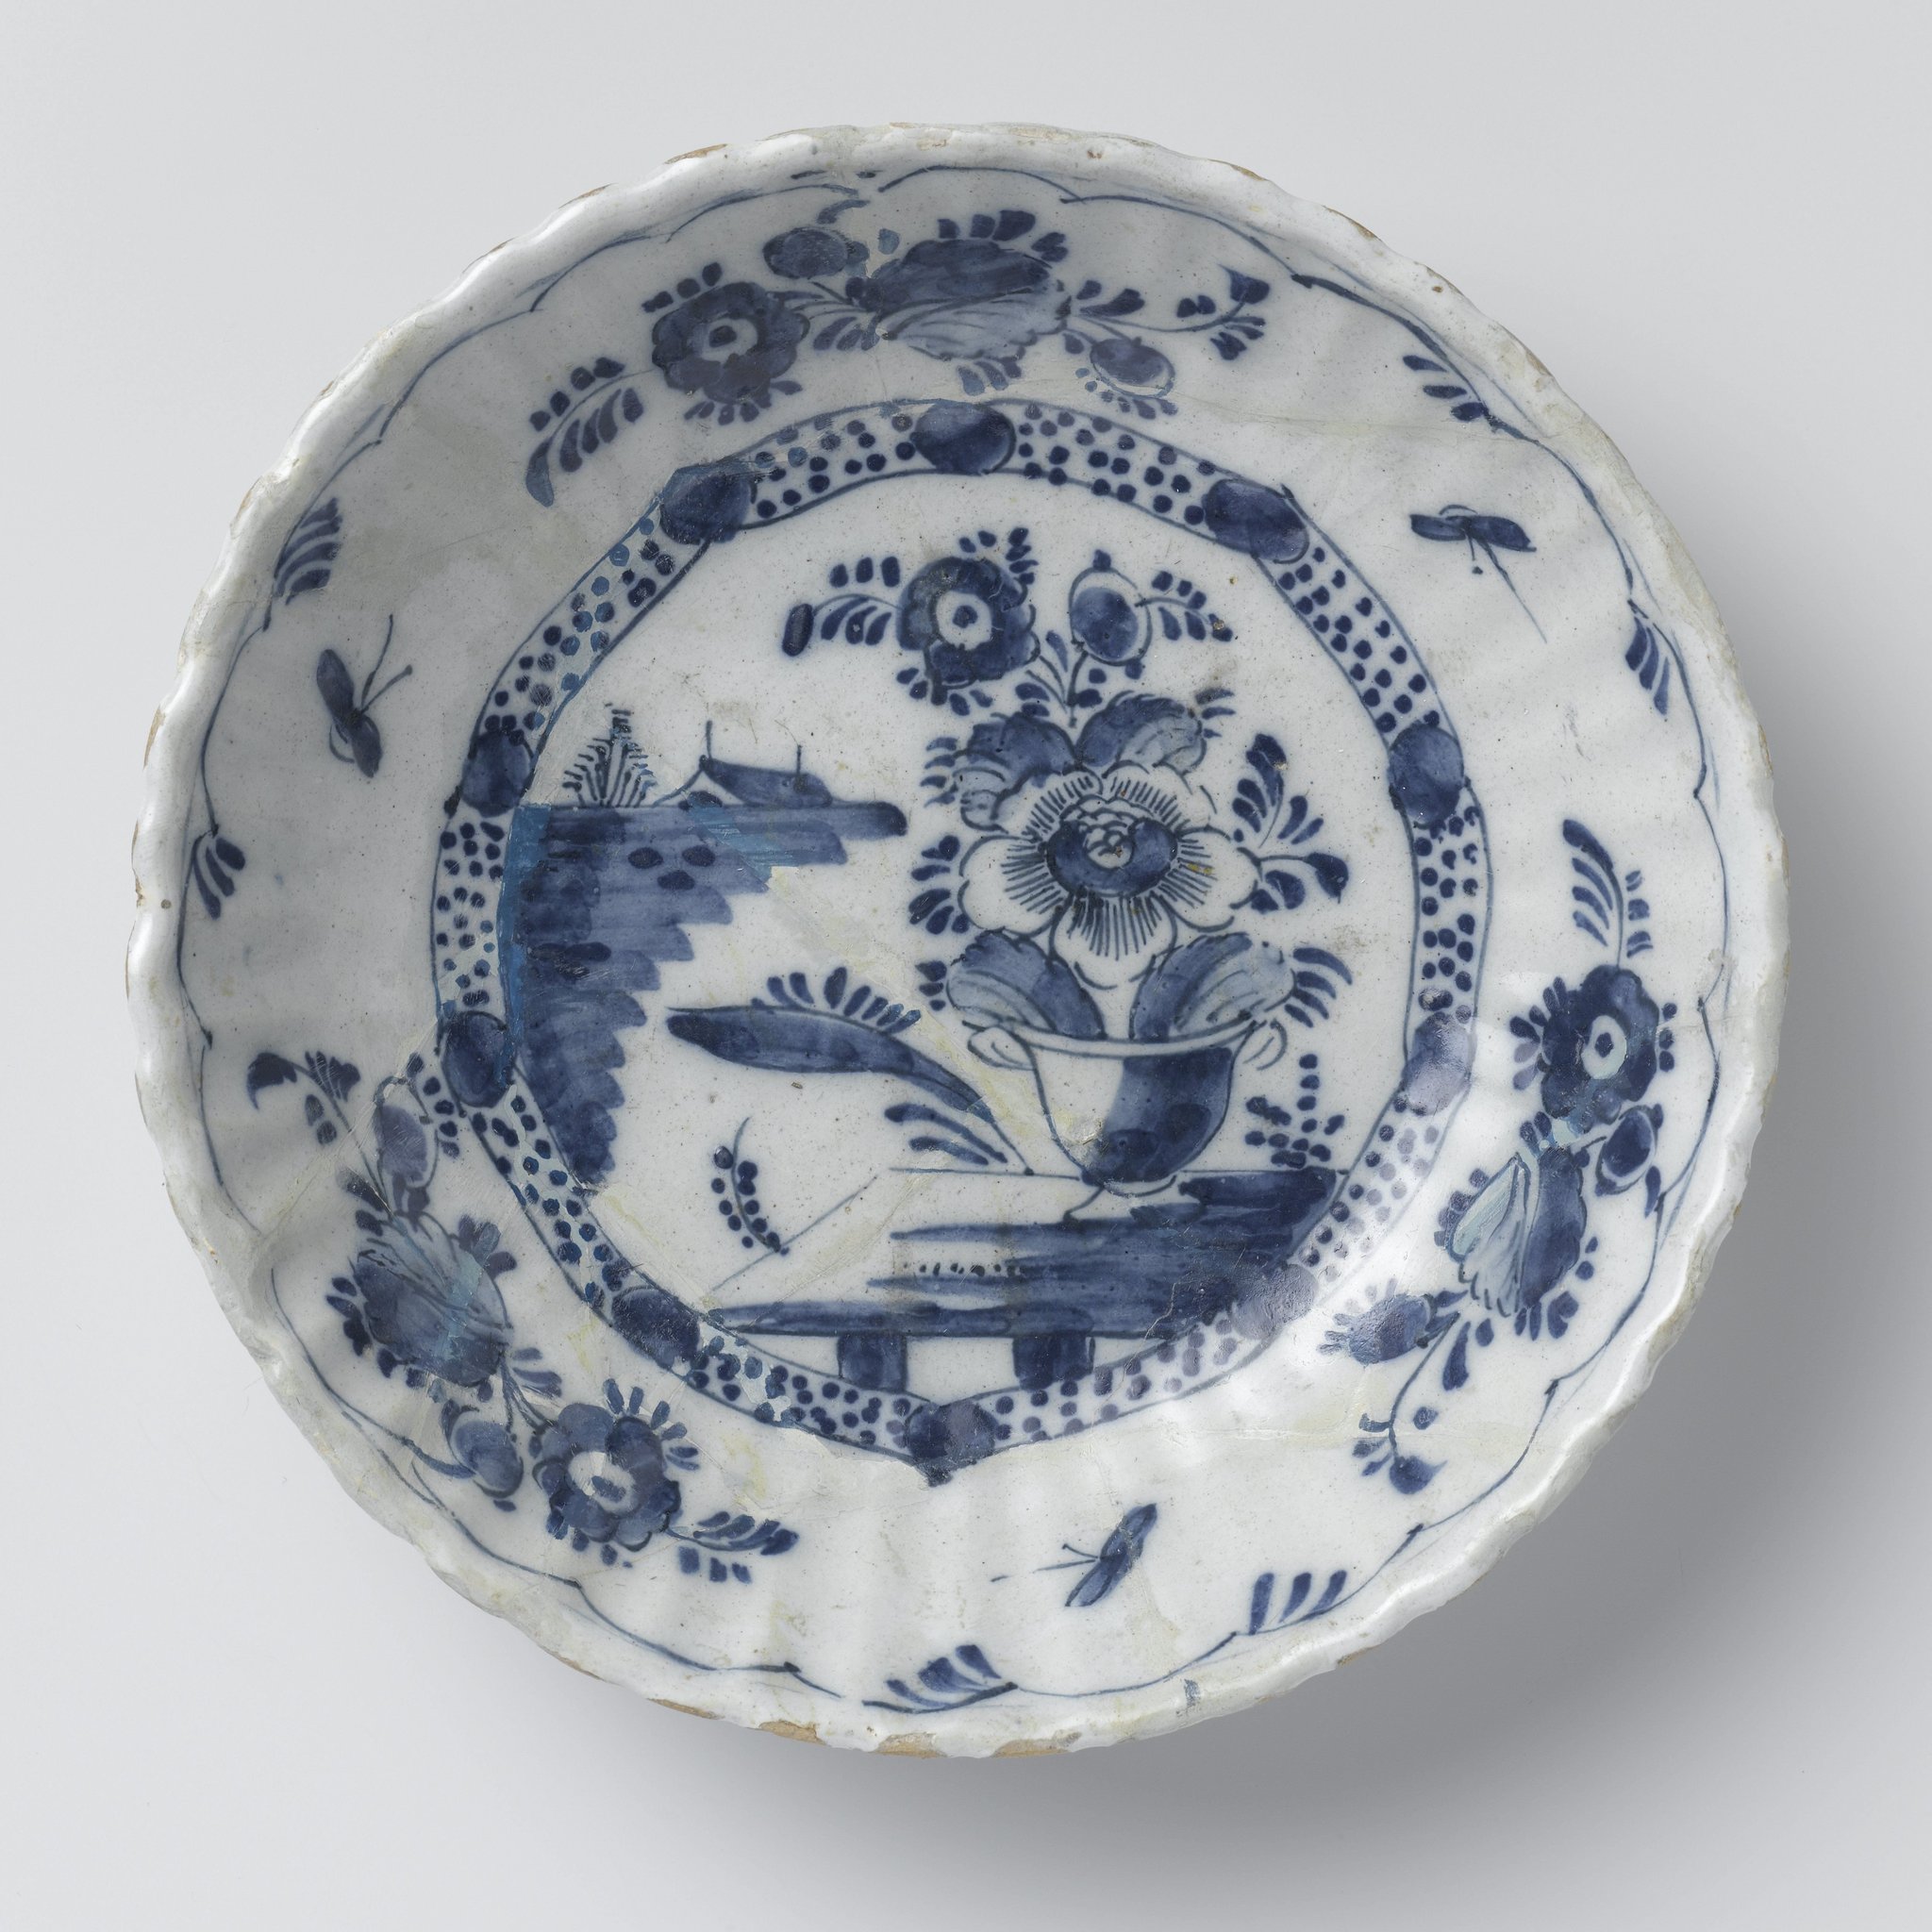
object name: platter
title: Schotel, geribd, op de bodem beschilderd met een bloempot op tafel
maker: Anonymous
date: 1725-1750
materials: faience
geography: delft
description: Schotel, geribd, op de bodem in blauw beschilderd met een bloempot op een tafel.